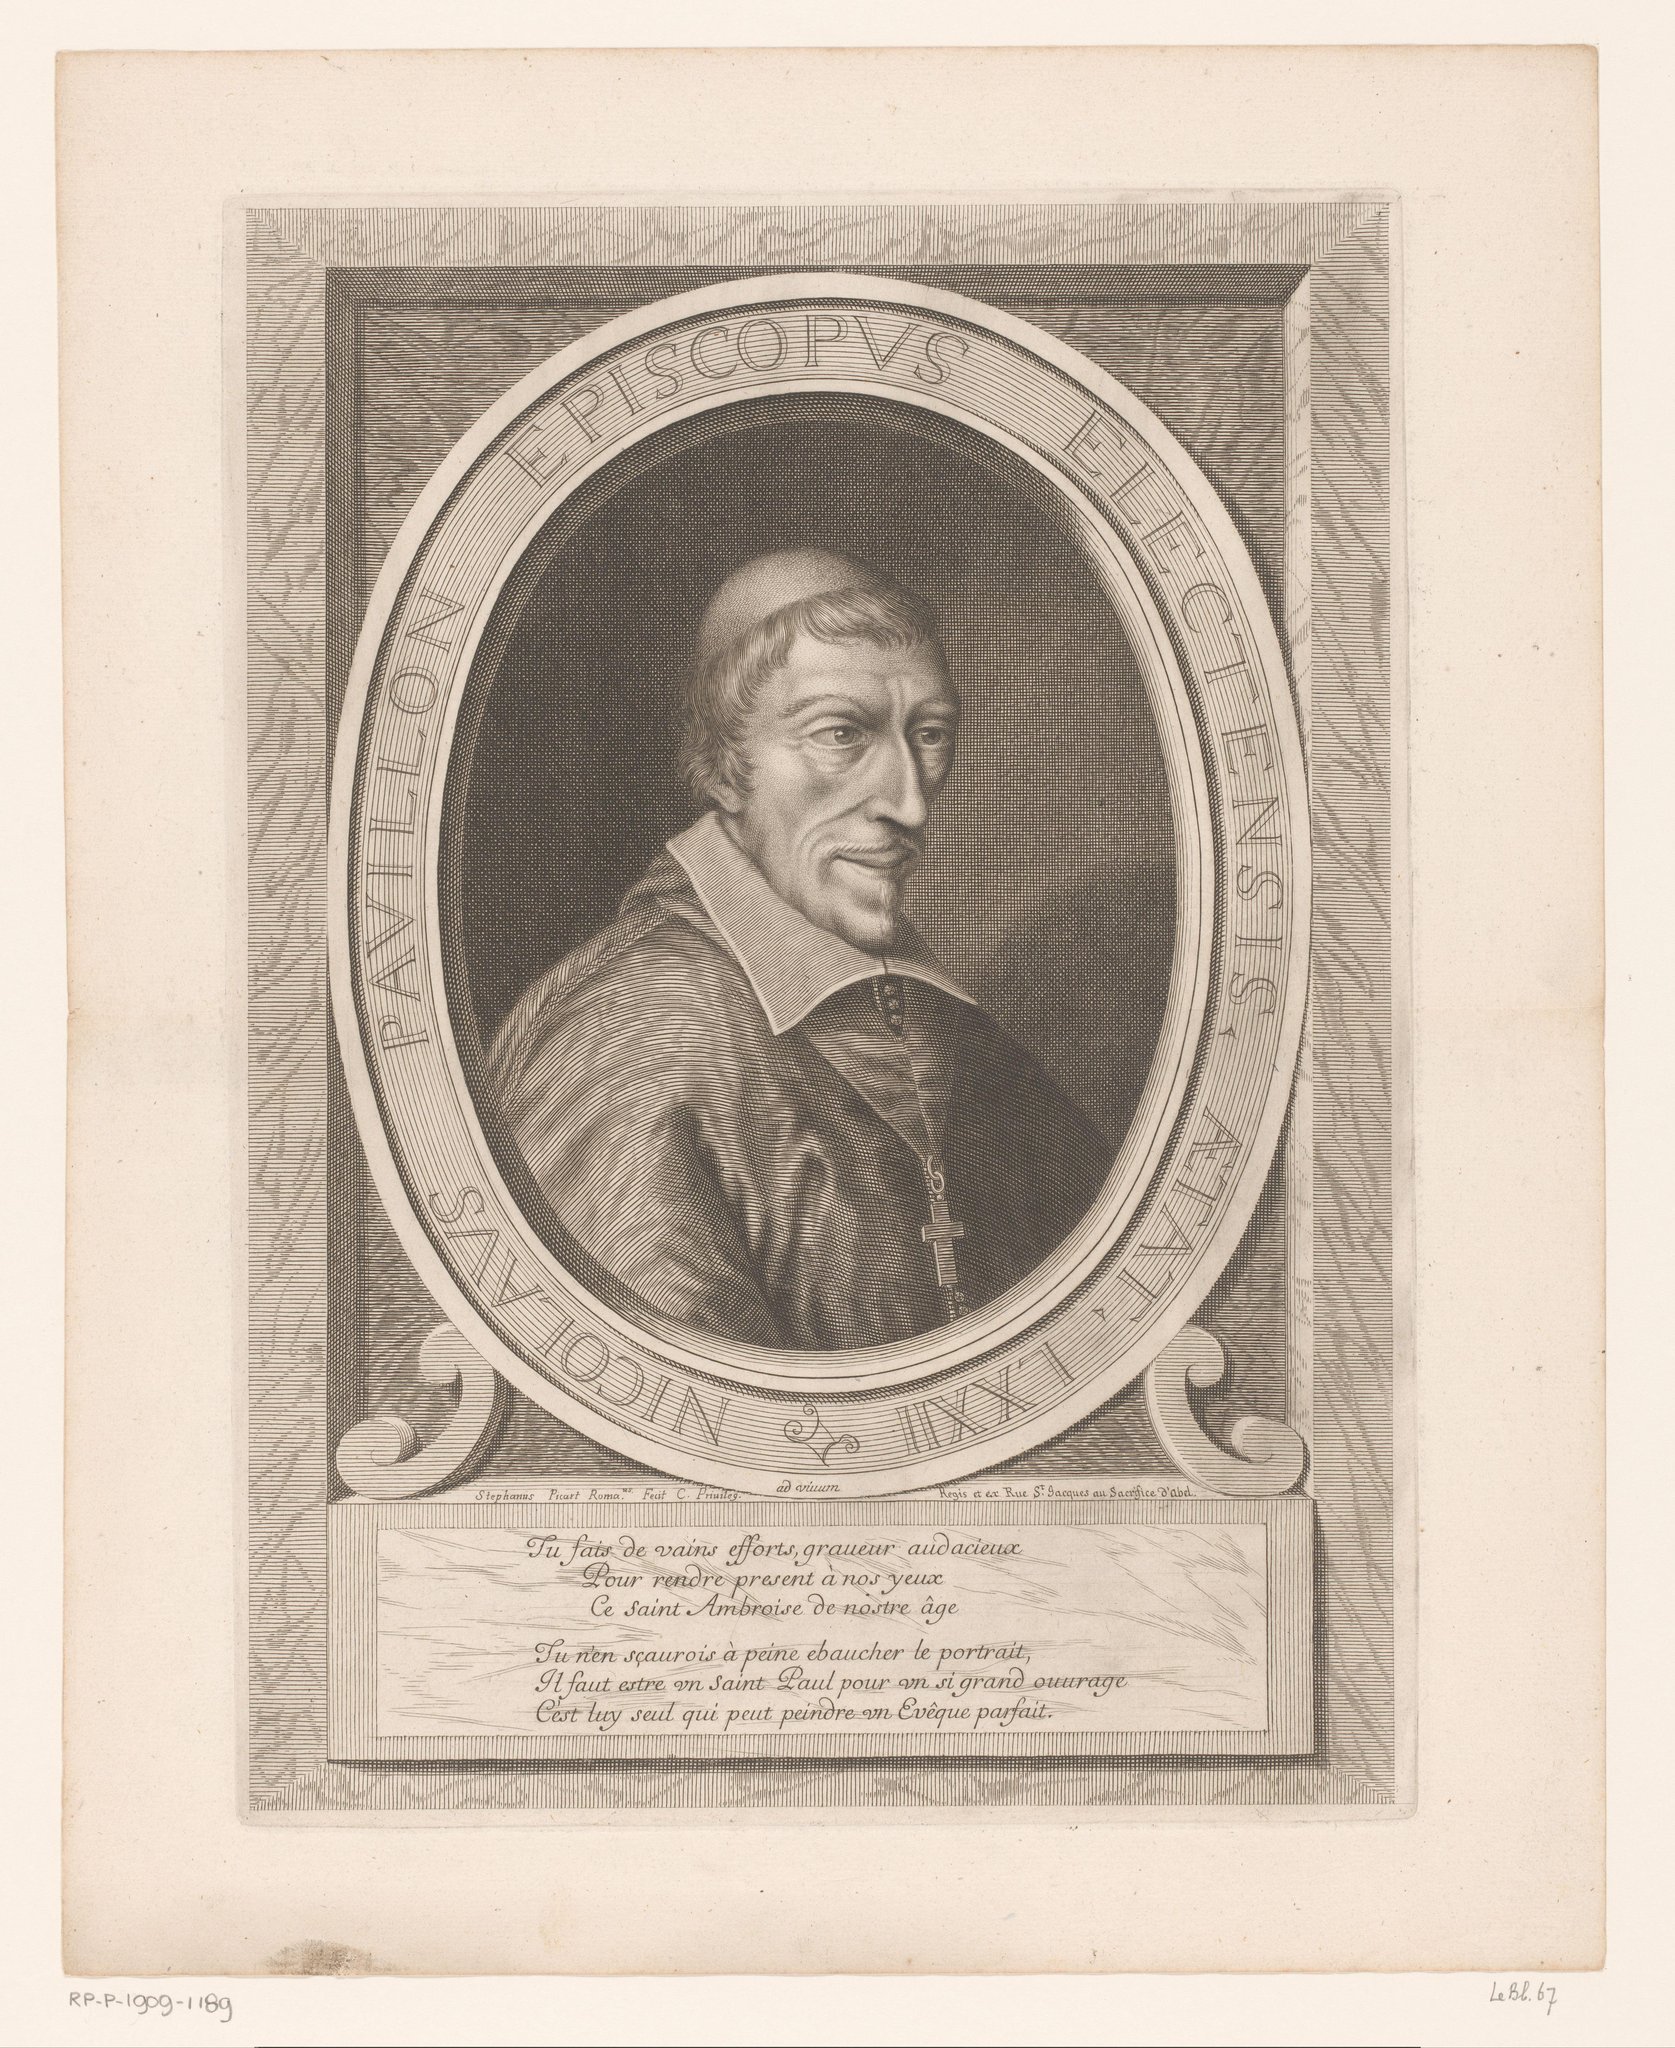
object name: print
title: Portret van Nicolas Pavillon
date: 1669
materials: paper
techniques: engraving, etching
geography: france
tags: paris, priest, archbishop, bishop, etc. (roman catholic), historical persons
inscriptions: collector's mark: Lugt 2228